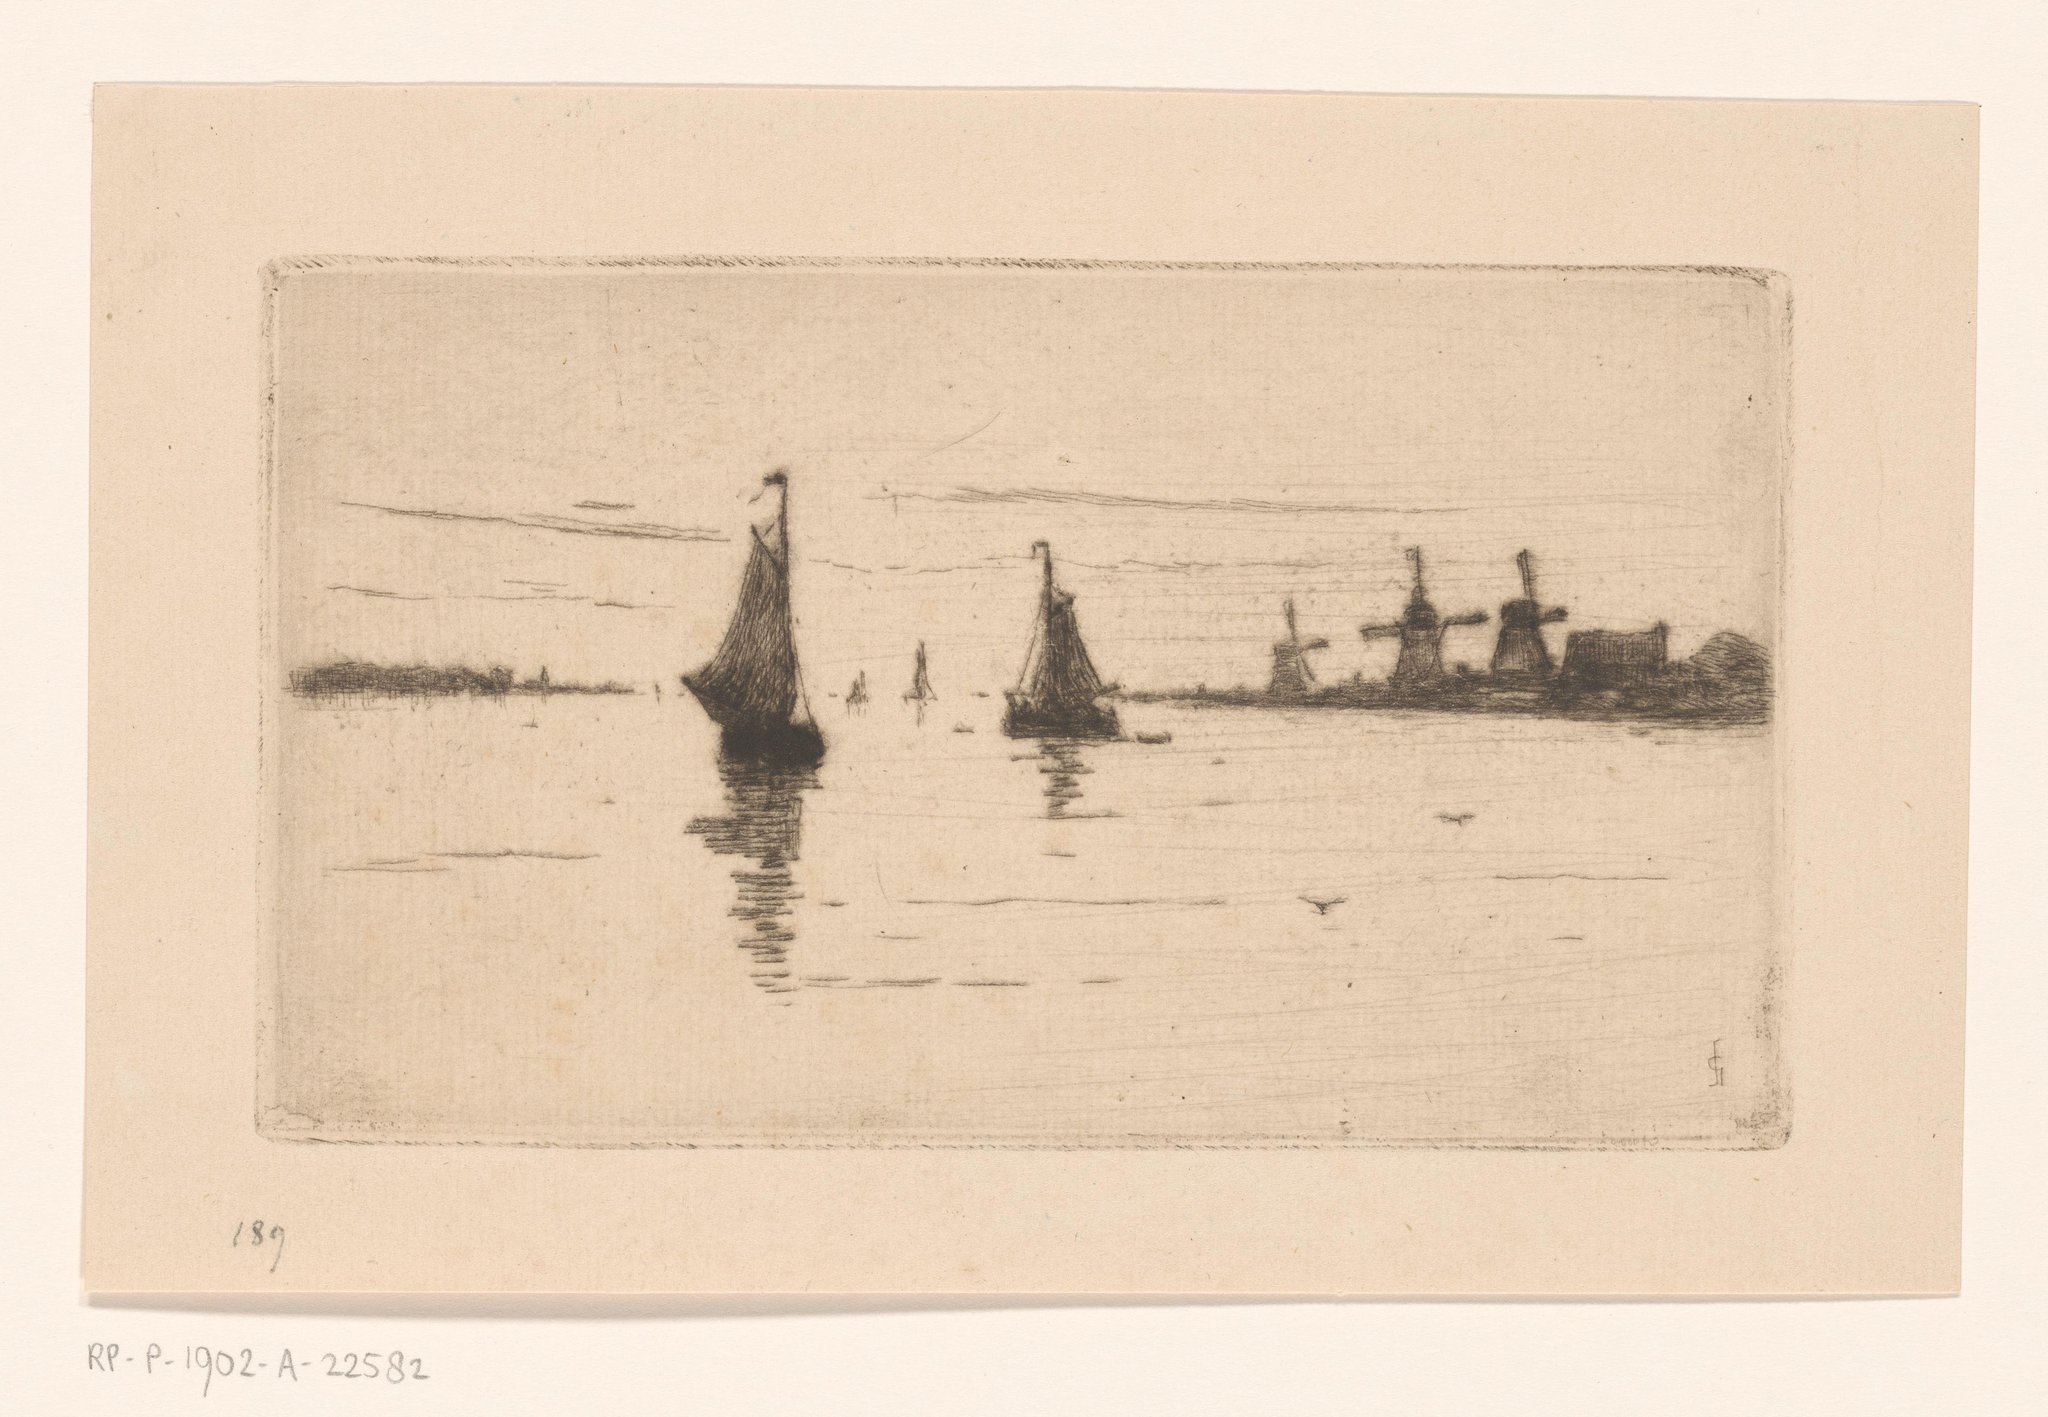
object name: print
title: Gezicht op de Maas bij Dordrecht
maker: carel nicolaas storm van s-gravesande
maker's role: draughtsman, print maker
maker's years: 1841-1924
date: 1851-1887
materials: paper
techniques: drypoint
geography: netherlands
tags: sailing-ship, sailing-boat, river, windmill in landscape, dordrecht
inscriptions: collector's mark: Lugt 2228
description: In het midden twee zeilboten. Rechts op de oever drie molens.